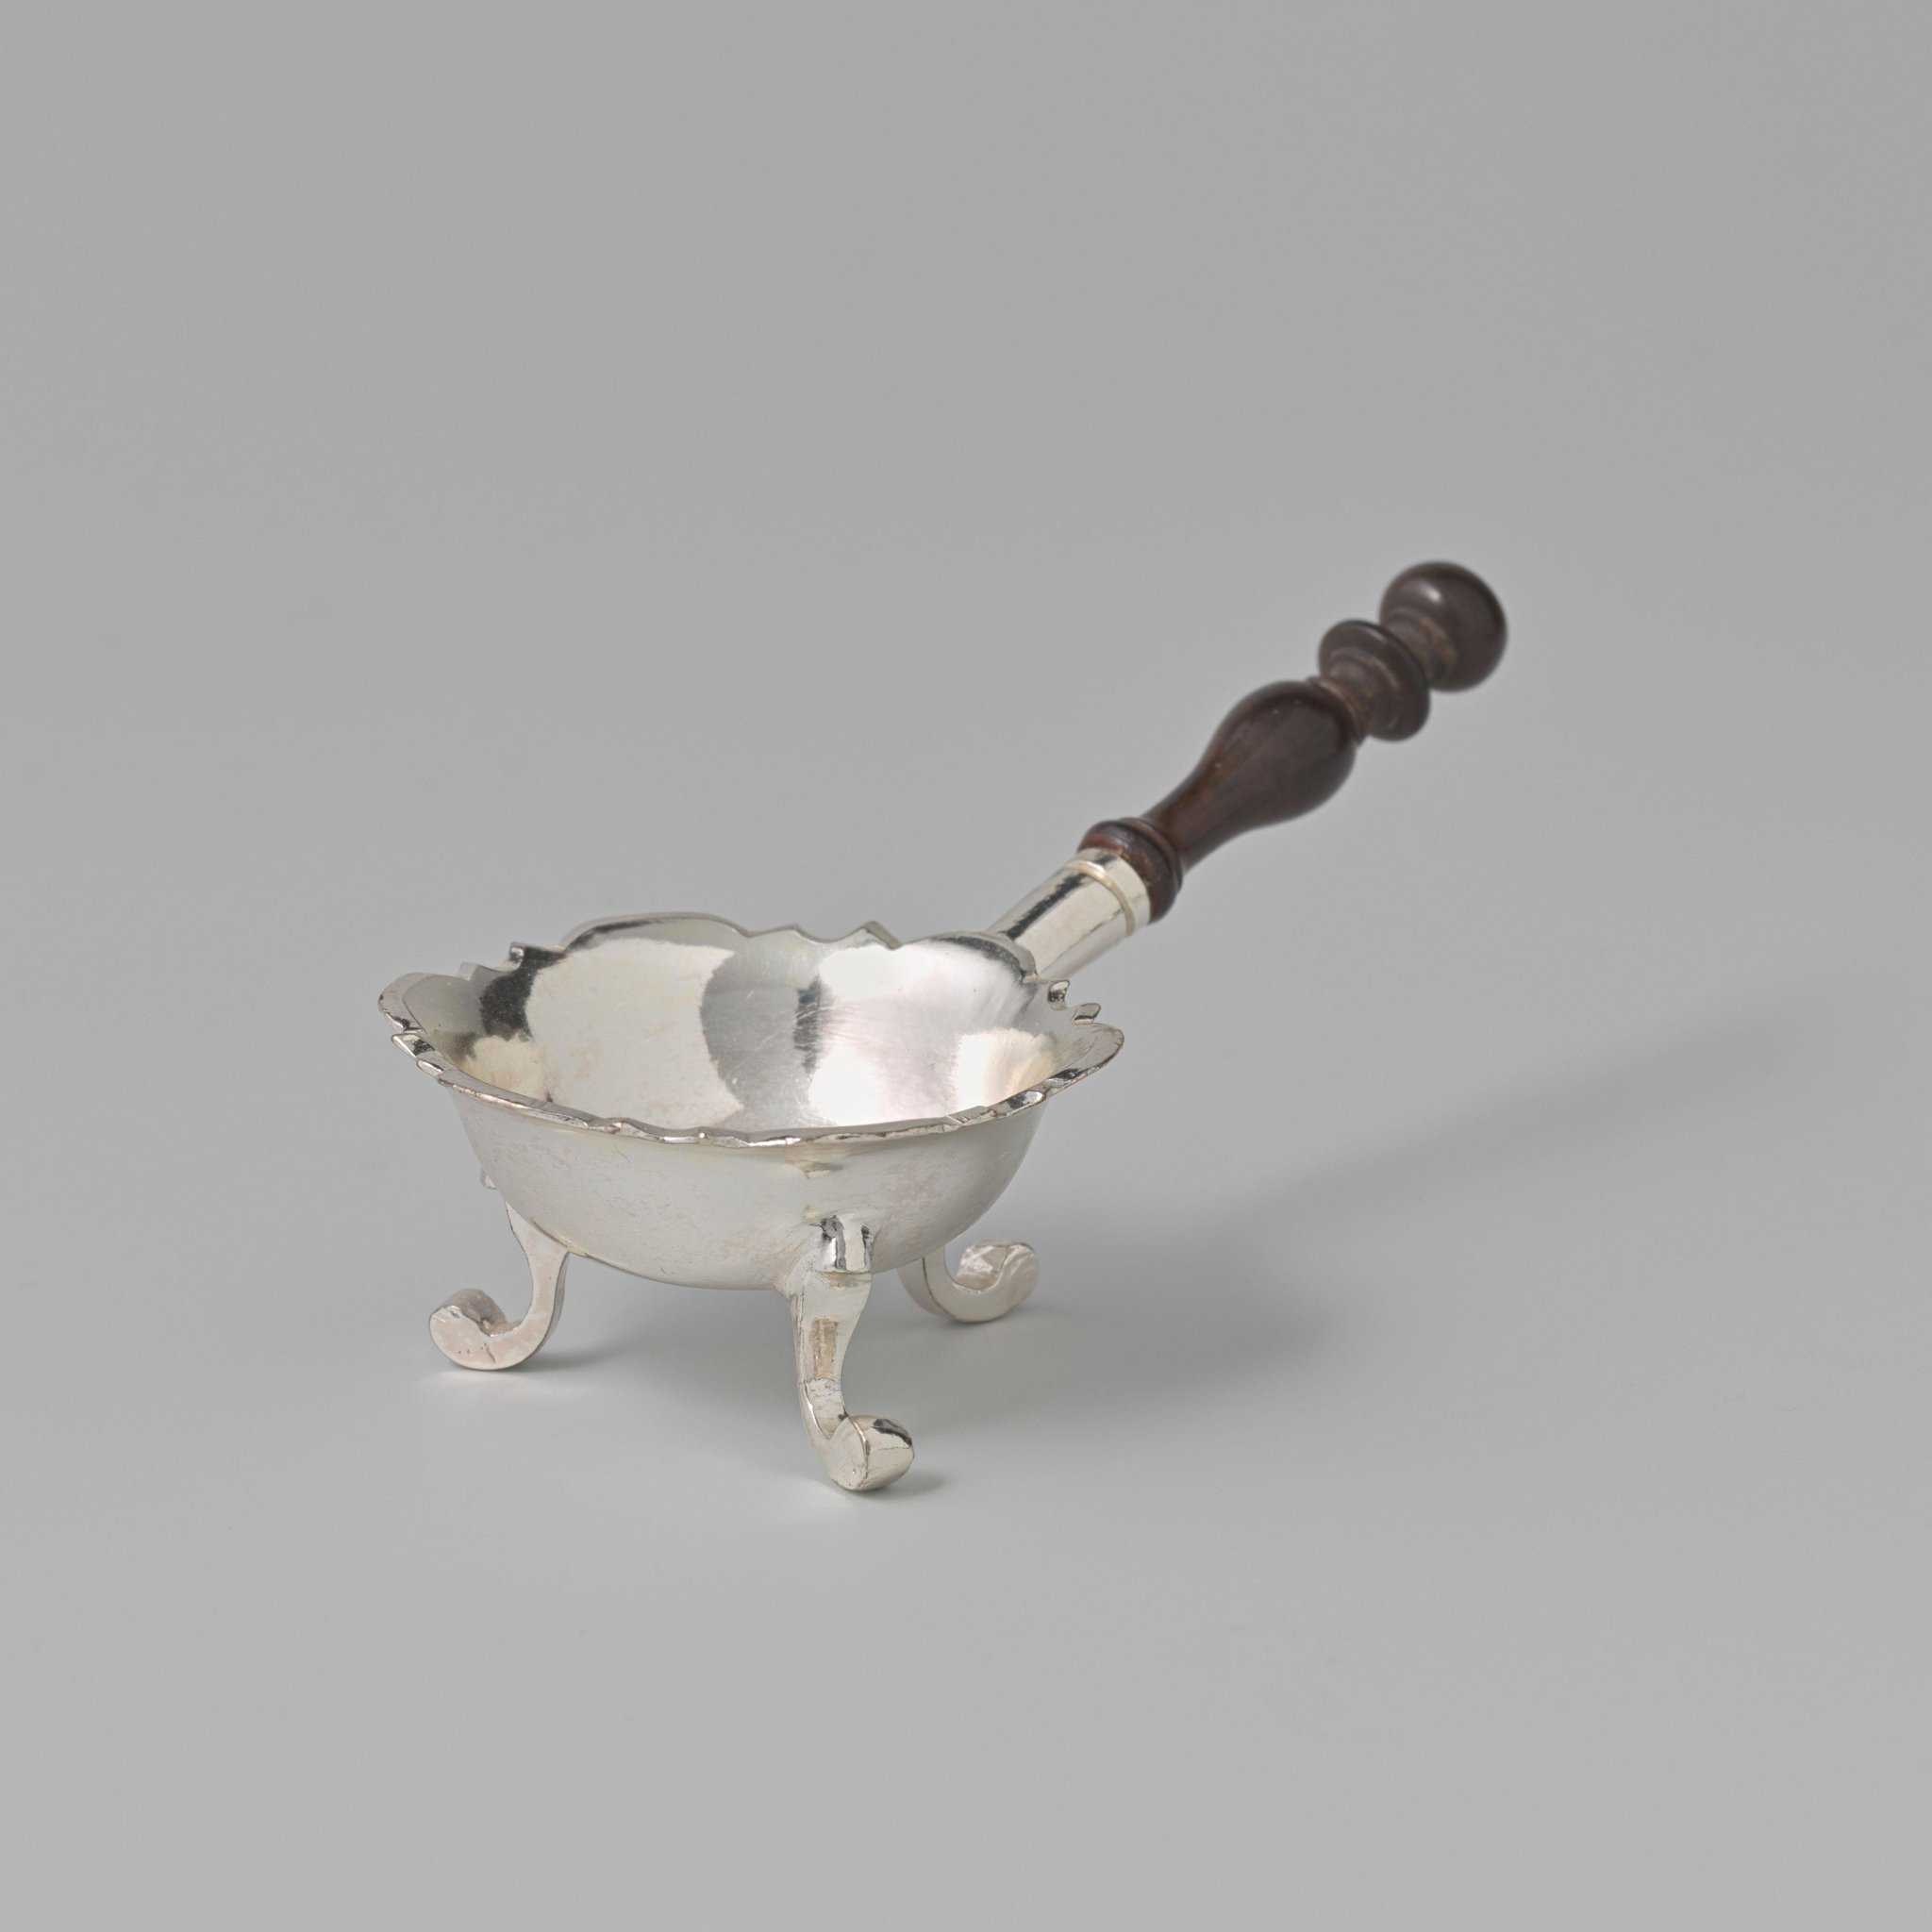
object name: miniature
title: Miniatuurpijpenkomfoor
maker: daniël van strant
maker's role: silversmith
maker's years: 1694-1756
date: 1755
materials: silver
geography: amsterdam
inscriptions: date letter: ‘V (=1755)’, maker's mark: ‘DVS (Citroen 1975, nr. 198)’, town mark: ‘kleine stadskeur Amsterdam’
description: Pijpenkomfoor van zilver op drie gebogen poten, ronde bak met geschulpte rand met ebbenhouten, gedraaide steel.